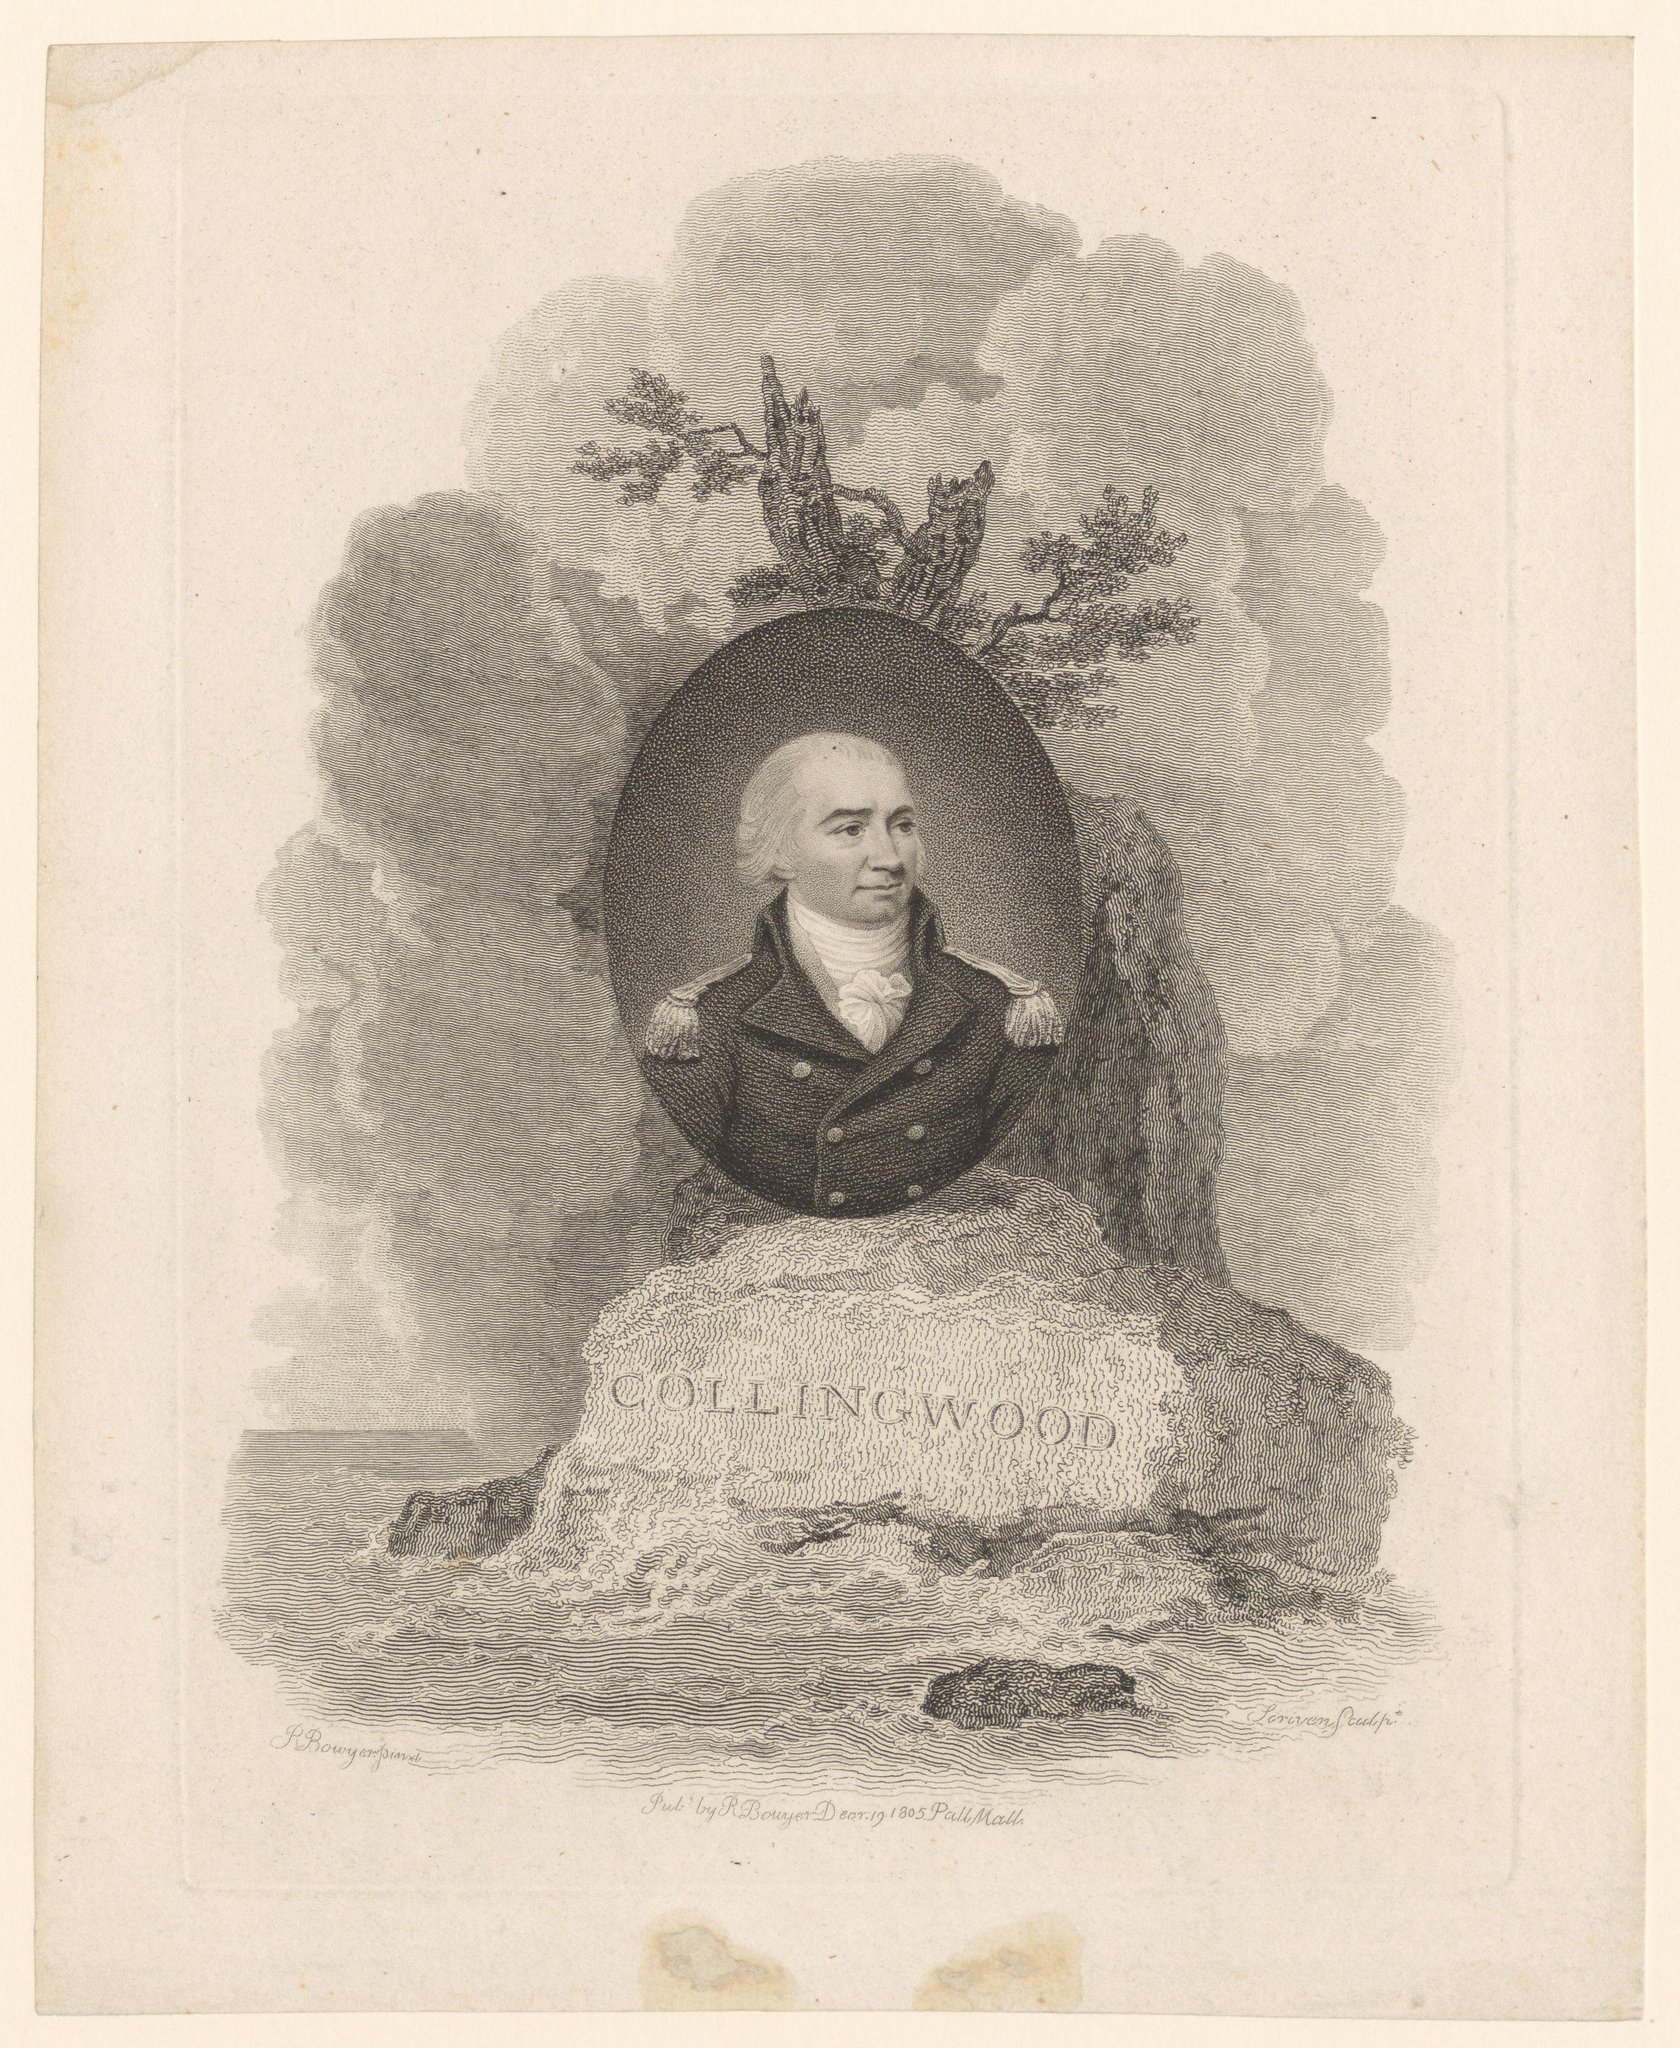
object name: print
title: Portret van Cuthbert Collingwood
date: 1805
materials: paper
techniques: etching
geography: london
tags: historical persons, commander-in-chief, admiral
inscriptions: collector's mark: Lugt 2228